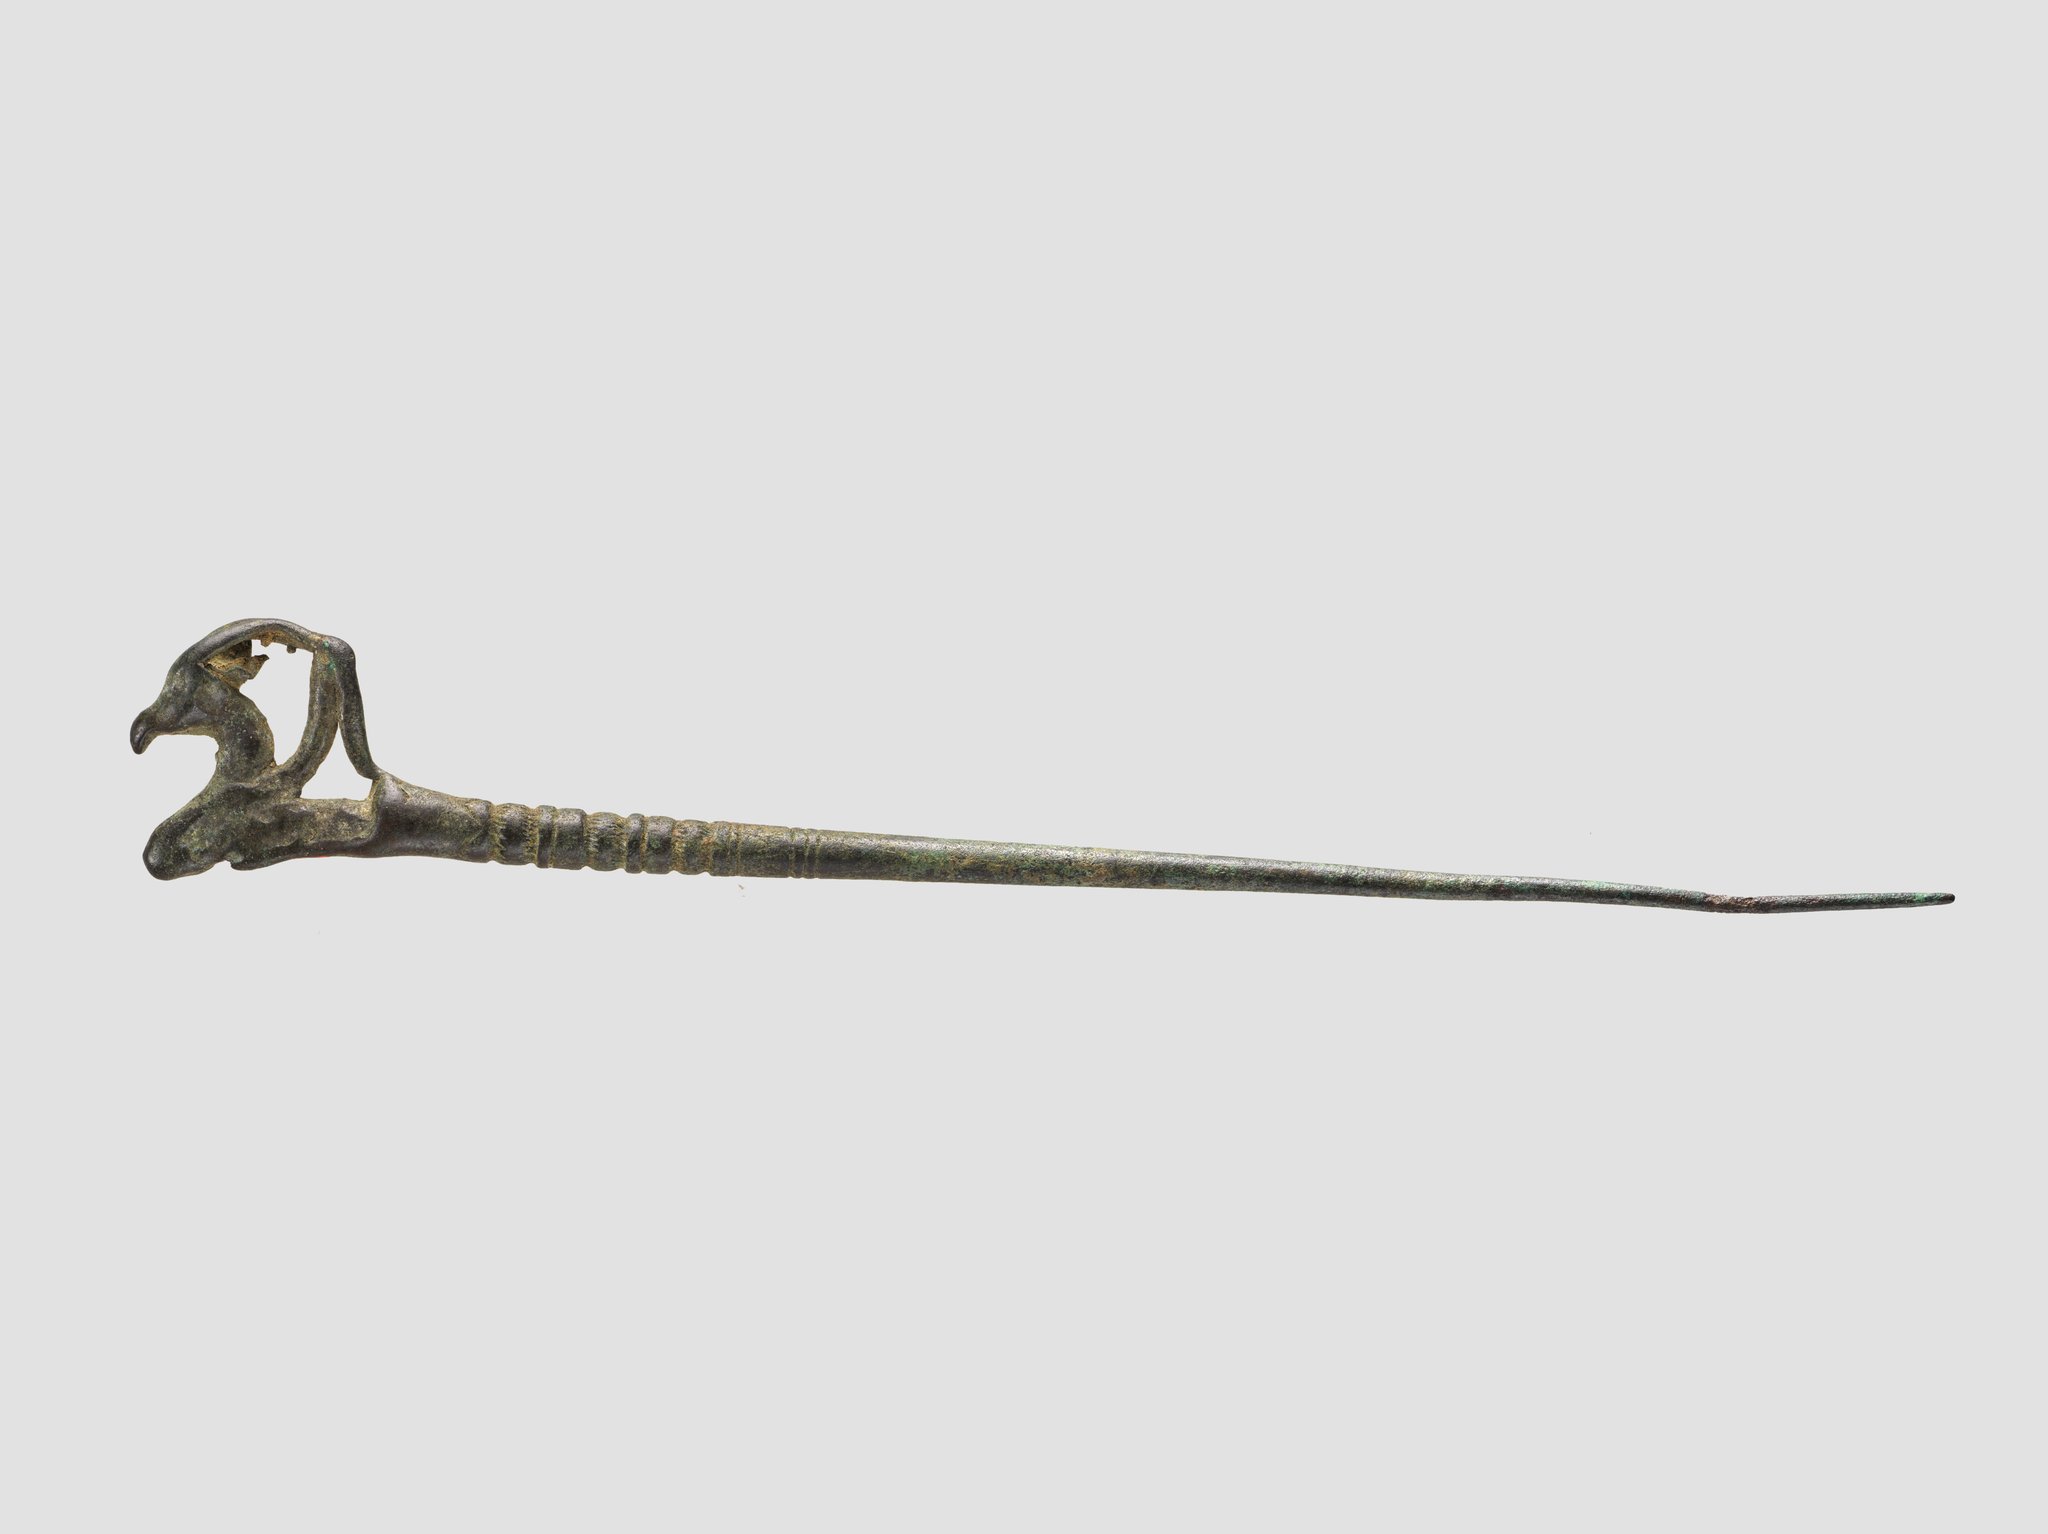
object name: pin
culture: iranian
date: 1000-1 BCE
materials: bronze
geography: western iran